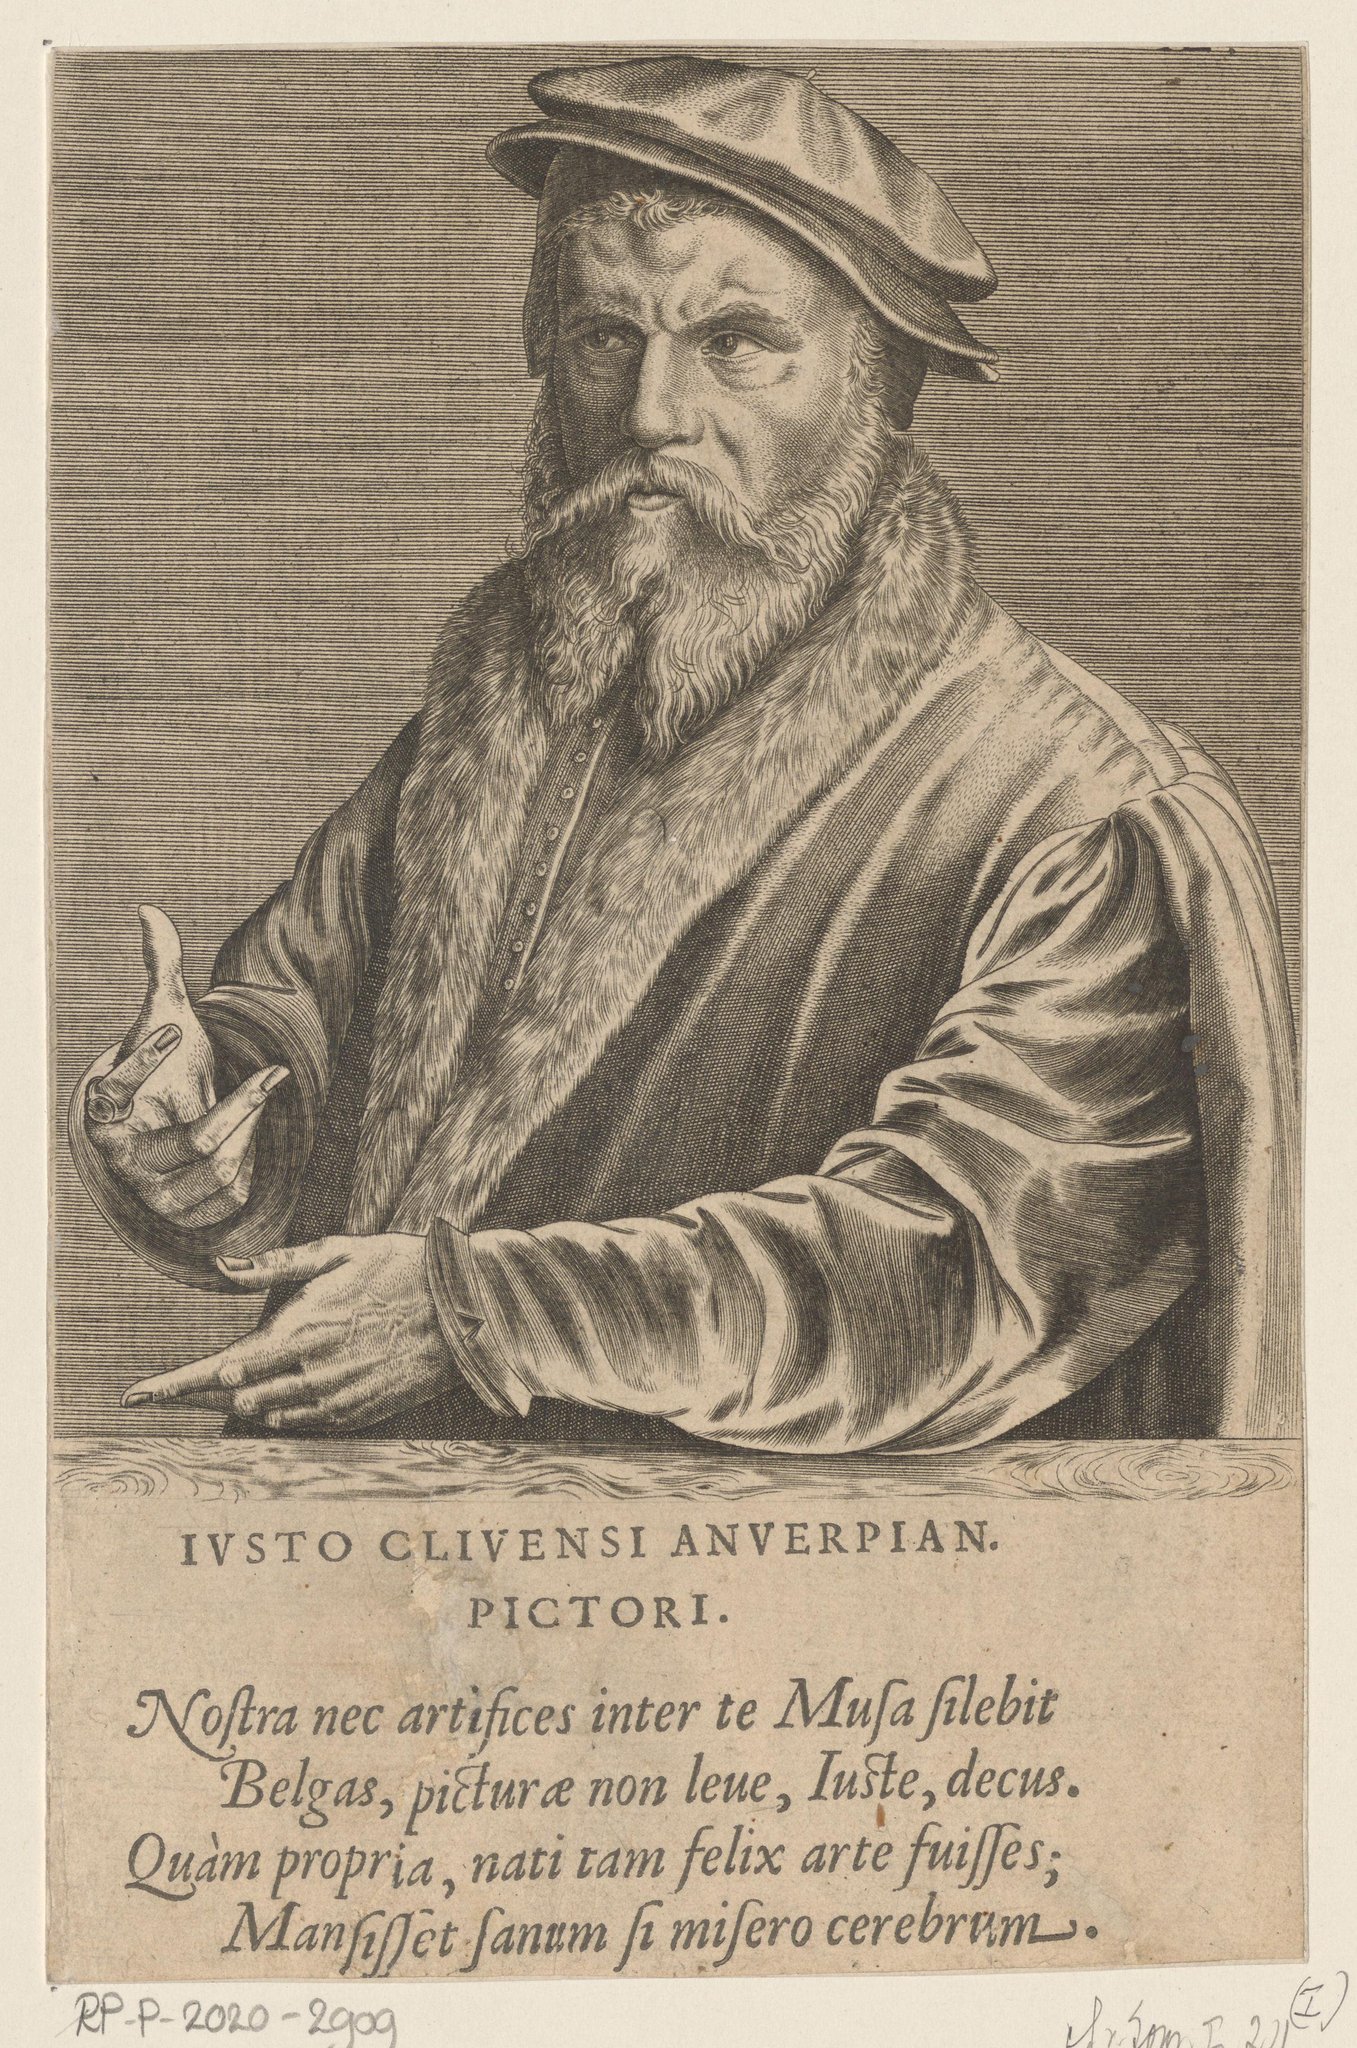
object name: print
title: Portret van Joos van Cleve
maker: Anonymous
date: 1572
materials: paper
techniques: engraving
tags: painter, draughtsman, joos van cleve, historical persons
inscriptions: collector's mark: Lugt 2165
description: Prent mogelijk uit: Pictorum aliquot celebrium praecipué Germaniae inferioris (...). Antwerpen: weduwe Hieronymus Cock, 1572.